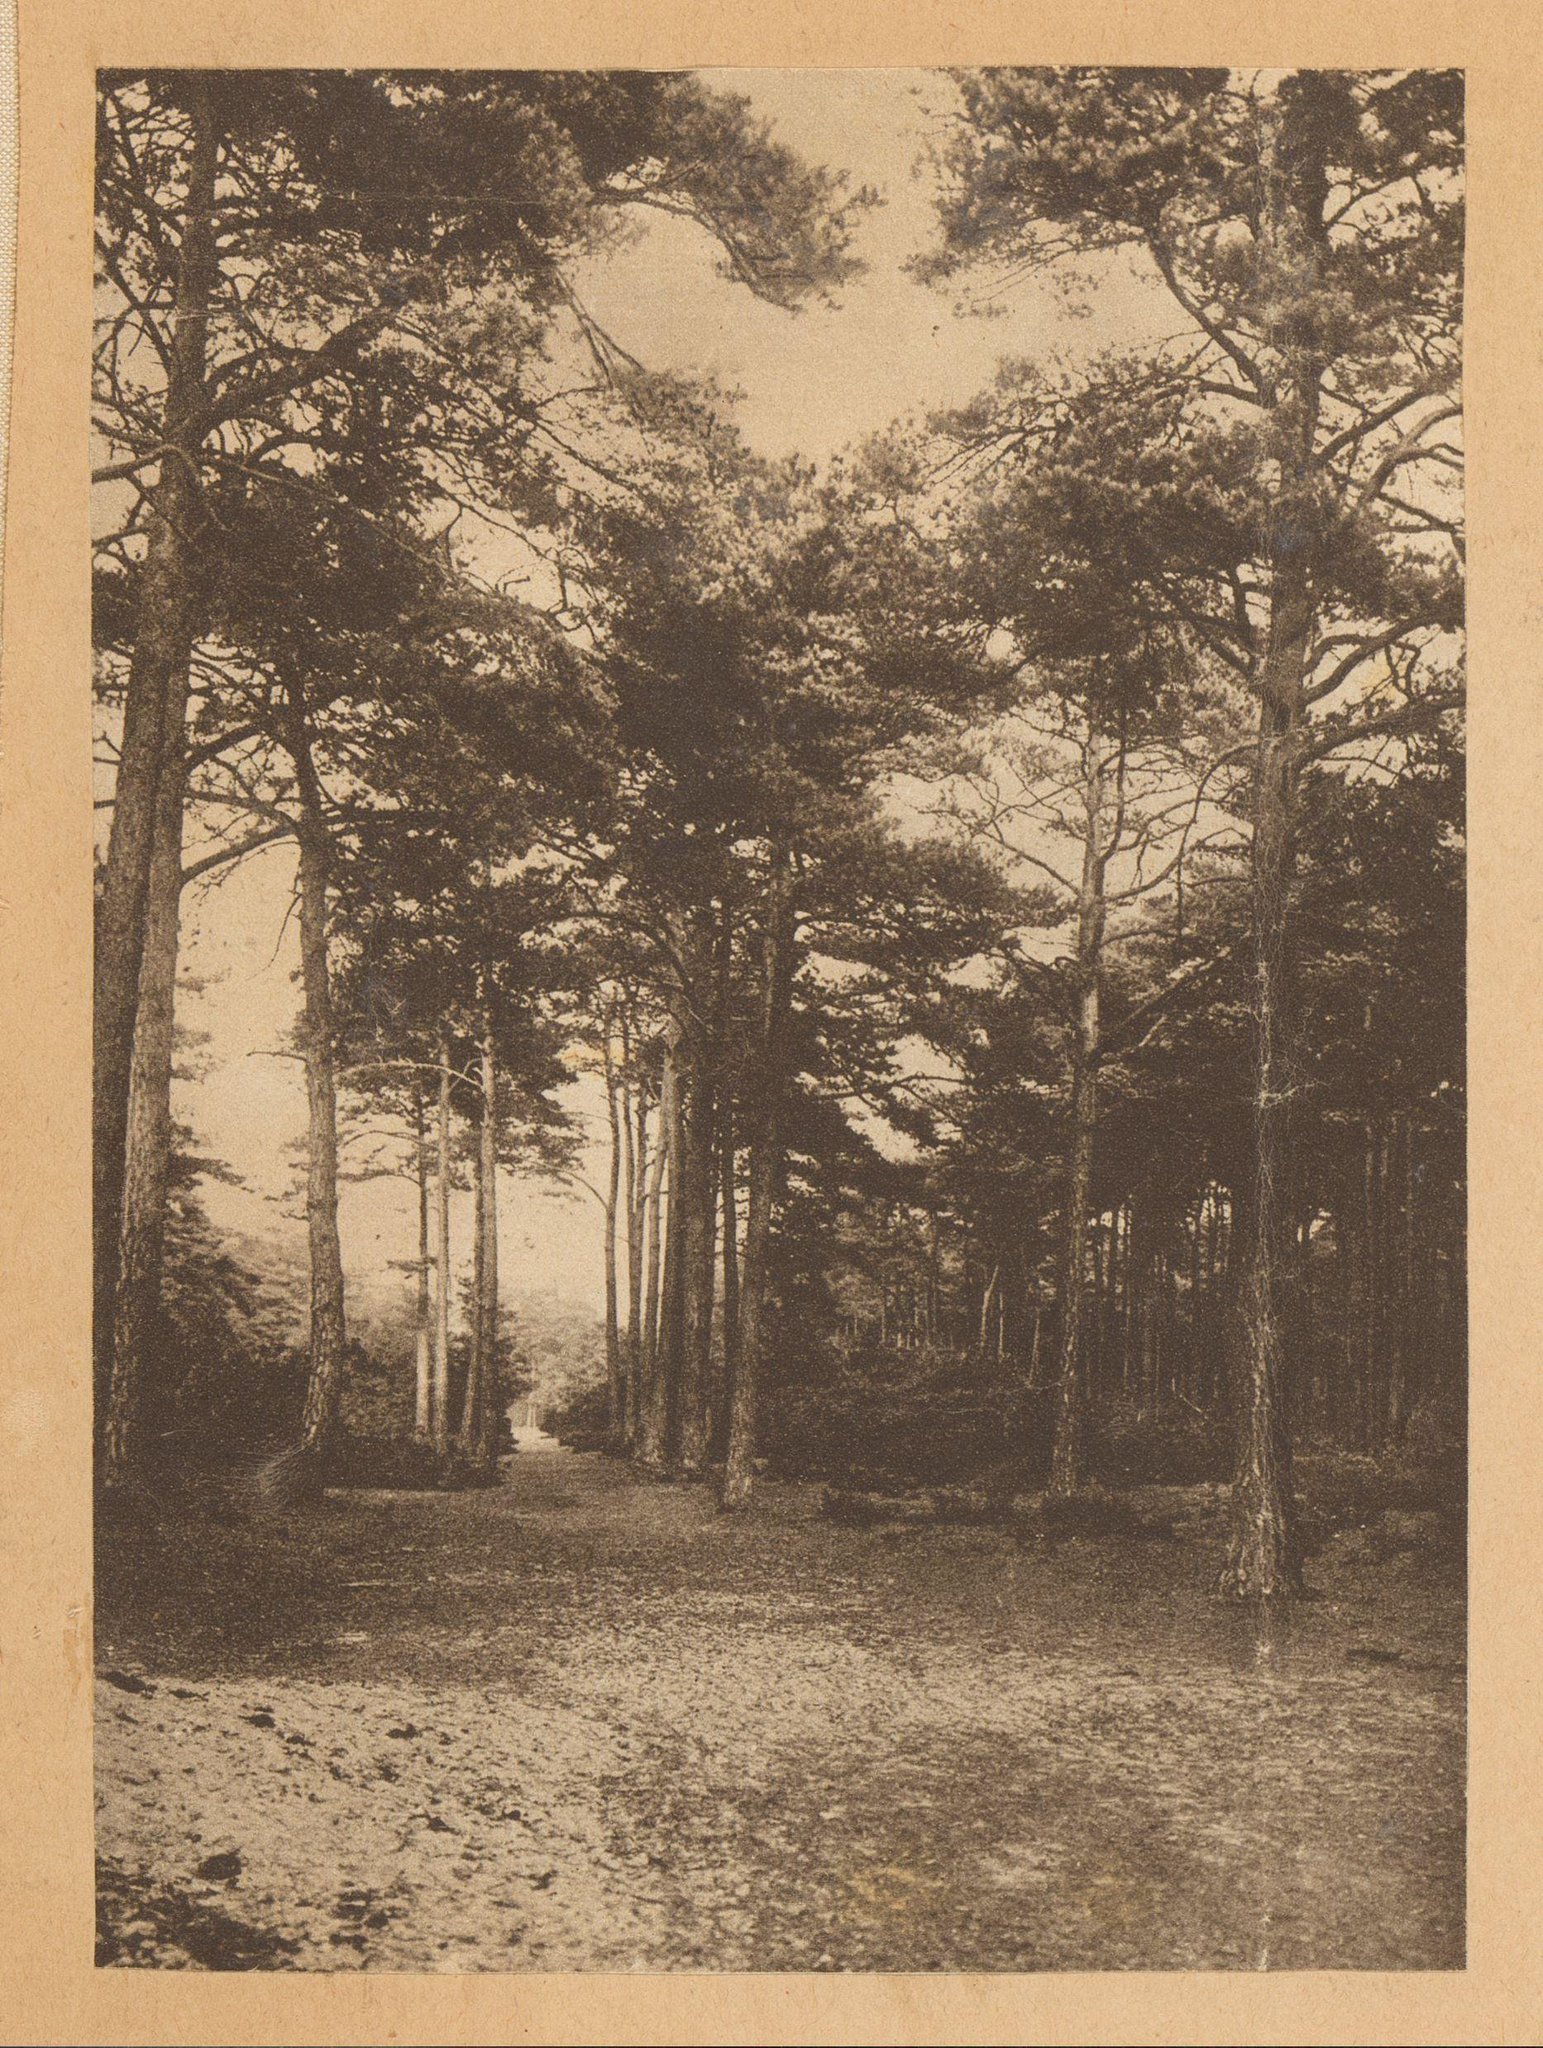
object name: photograph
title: Pad in boslandschap, vermoedelijk in Nederland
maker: Anonymous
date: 1900-1920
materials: paper, ink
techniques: rotogravure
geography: netherlands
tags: trees, forest path or lane, netherlands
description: Onderdeel van Familiealbum met foto's van een familie in de voormalige kolonie Nederlands-Indië en van een suikerfabriek in Purworejo.